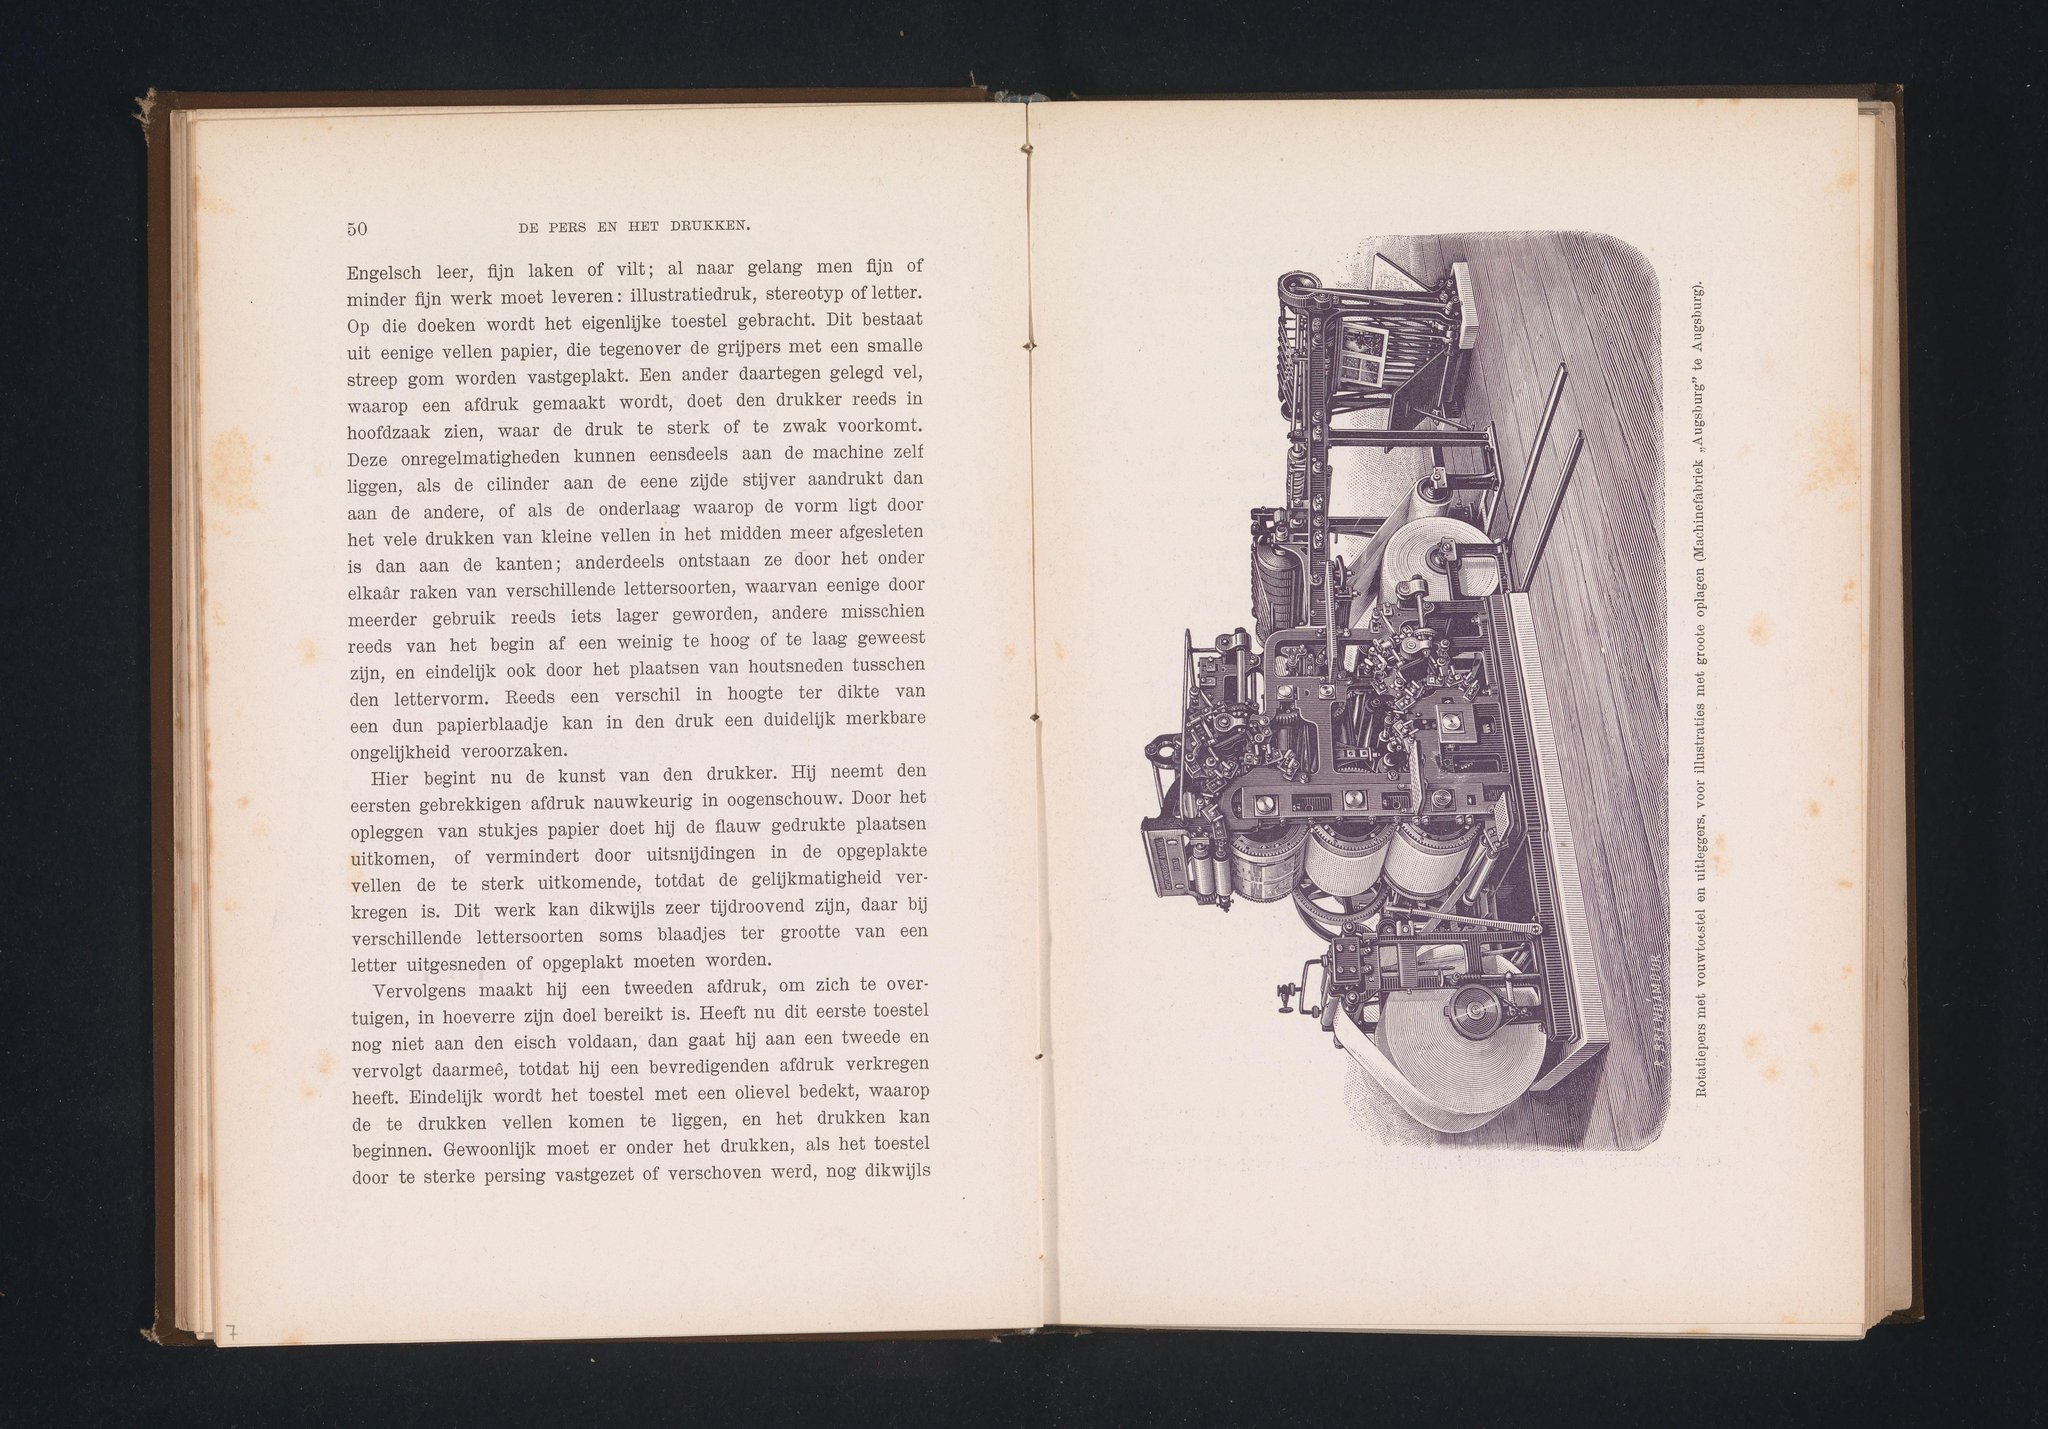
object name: reproduction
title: Rotatiepers met vouwtoestel en uitleggers, voor illustraties met groote oplagen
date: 1887-1892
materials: paper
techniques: printing block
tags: printing press